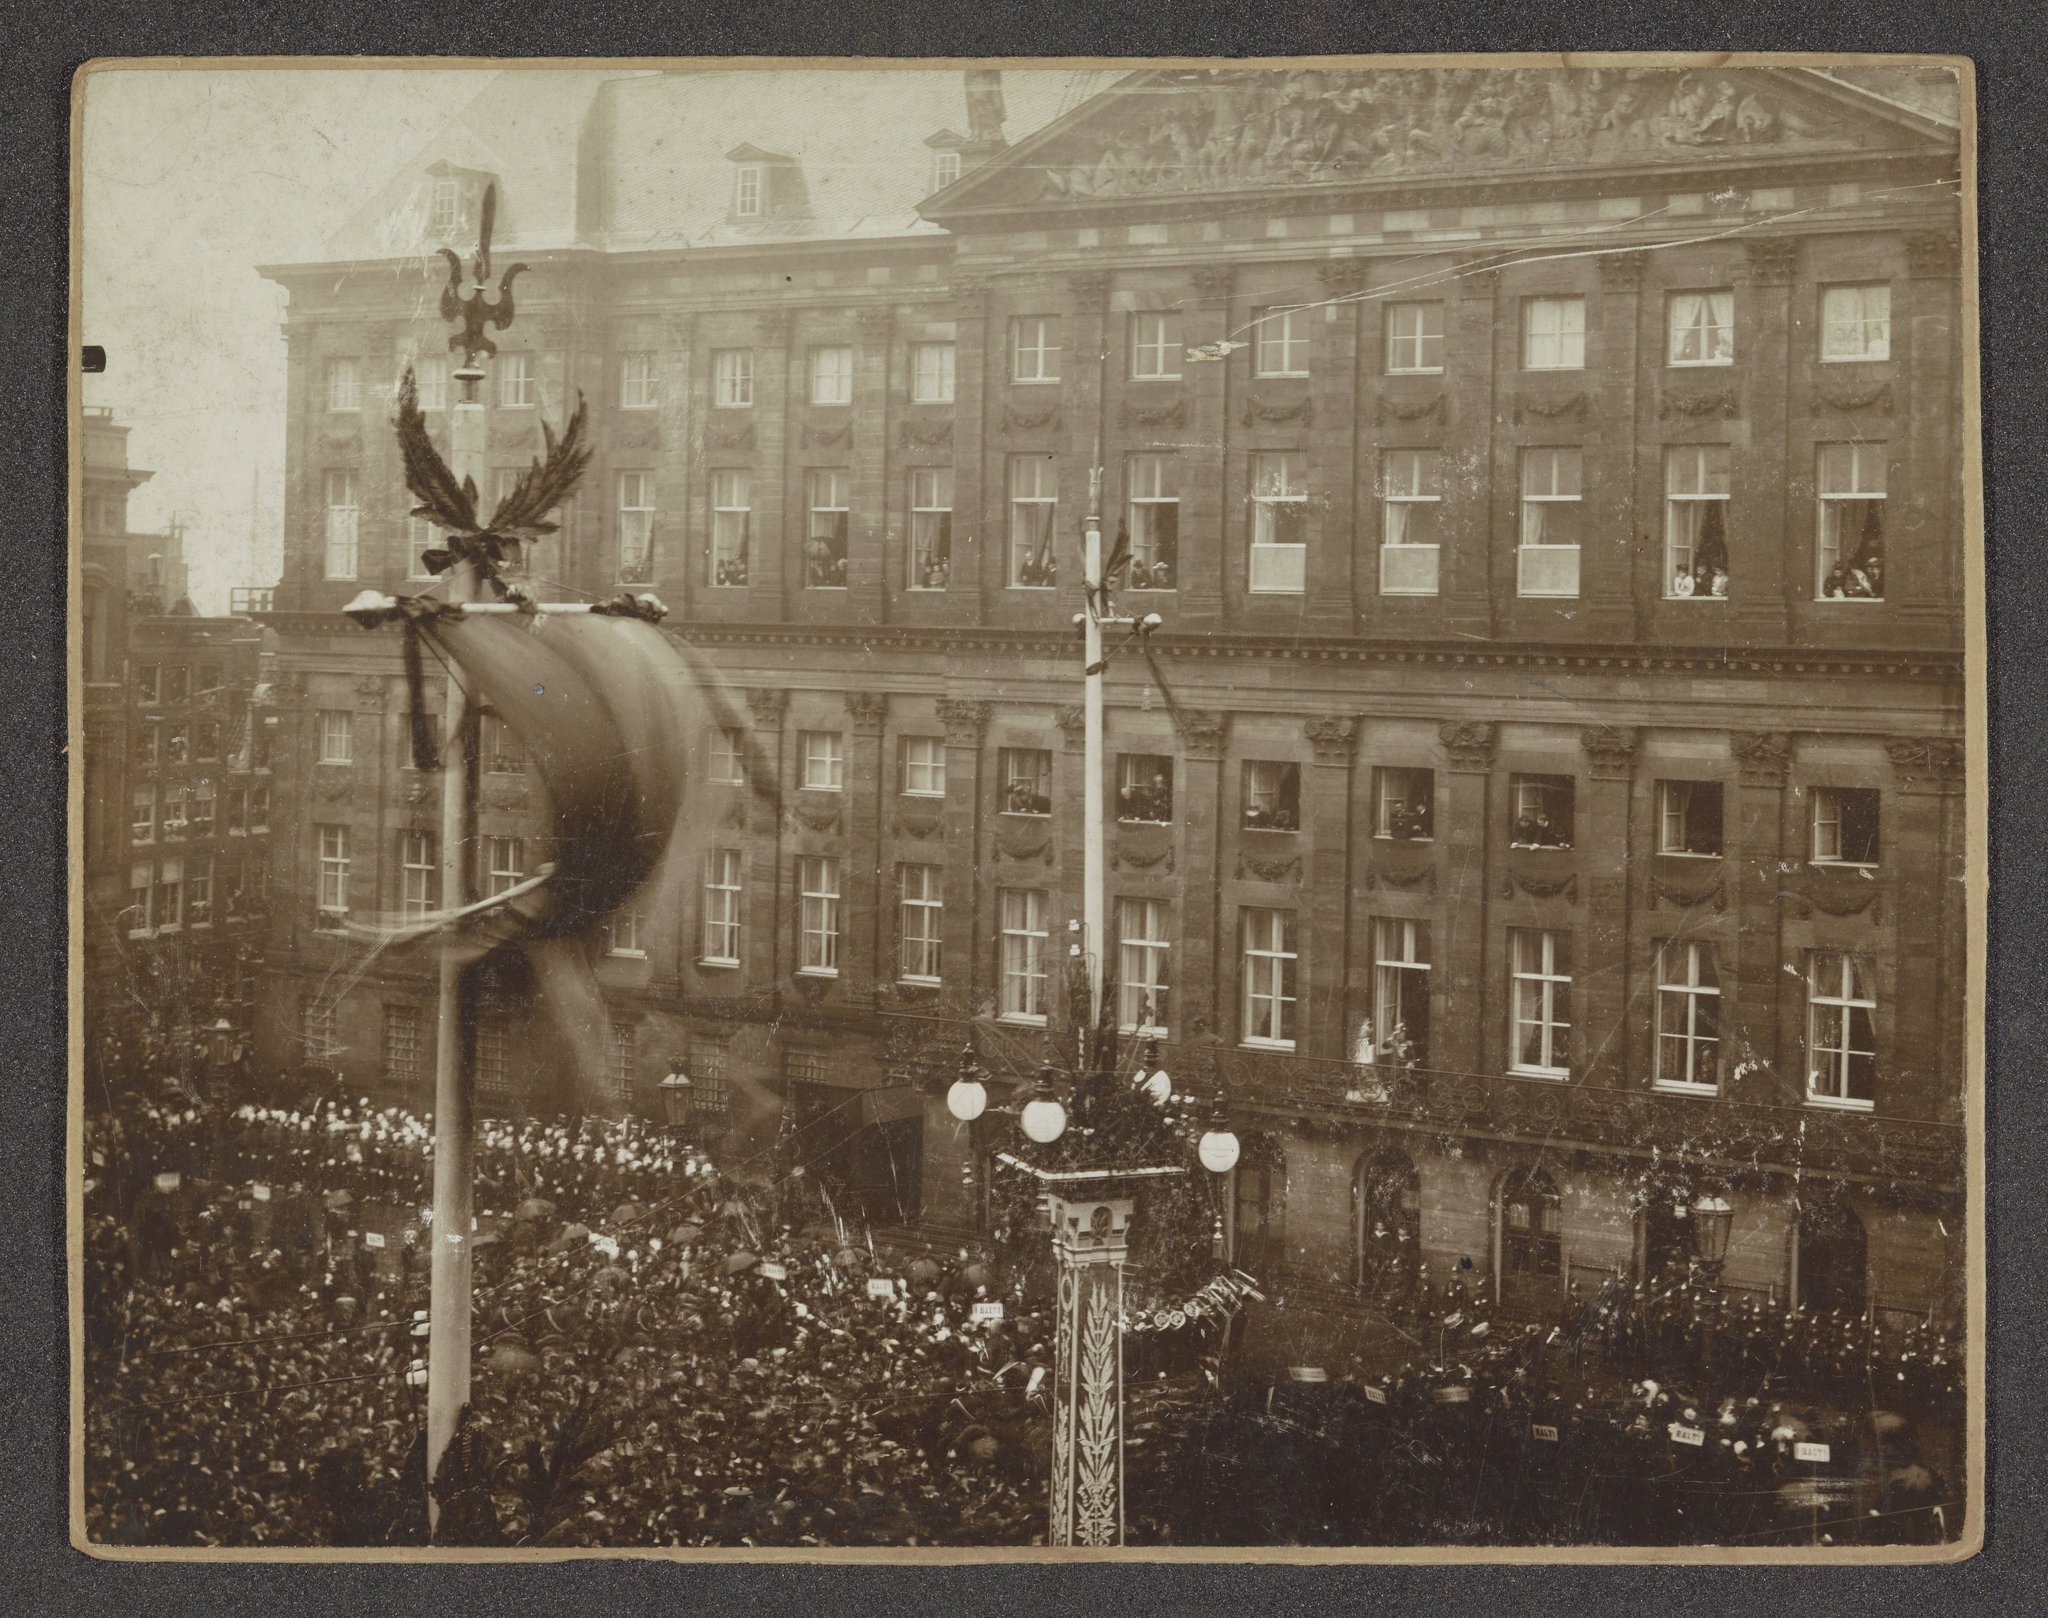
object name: photograph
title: Koningin Wilhelmina en prins Hendrik op het balkon van het Paleis op de Dam in Amsterdam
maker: Anonymous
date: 1901-1915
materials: cardboard, photographic support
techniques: collodion silver print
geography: amsterdam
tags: the hague, print maker, wilhelmina of the netherlands, hendrik (prins der nederlanden (1876-1934)), amsterdam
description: foto is vermoedelijk genomen ter gelegenheid van het huwelijk van koning Wilhelmina en Prins Hendrik